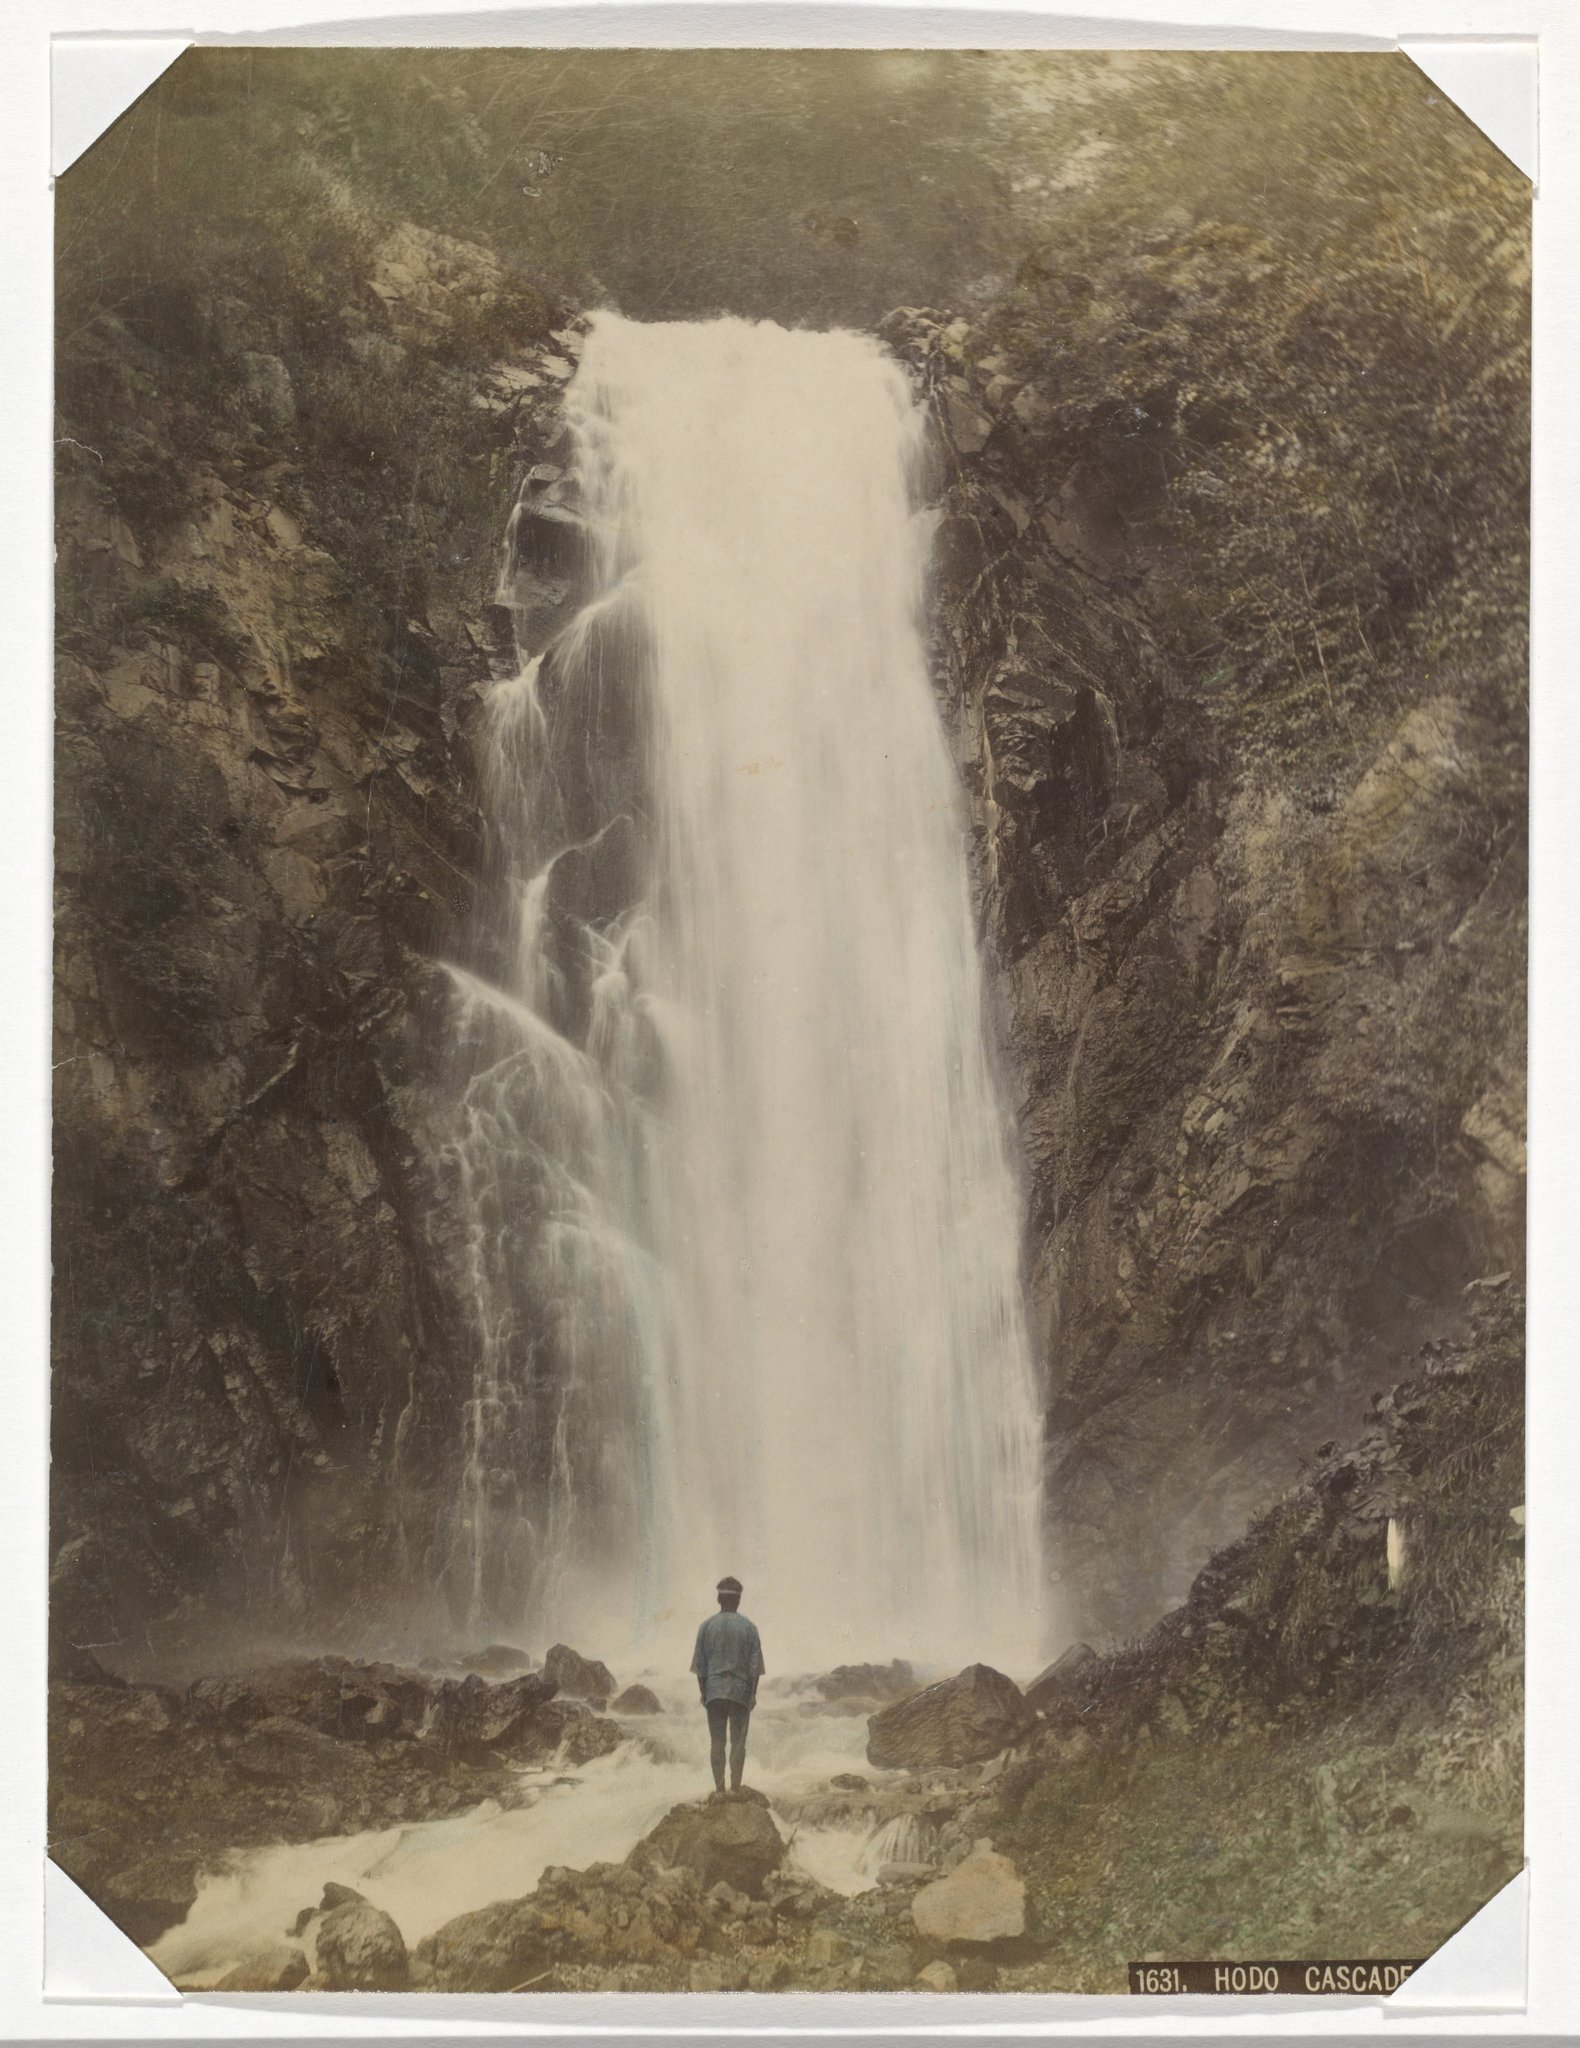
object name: photograph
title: Hodo-waterval bij Nikko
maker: raimund von stillfried-ratenitz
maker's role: painter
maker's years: 1839-1911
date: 1871-1885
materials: cardboard, paper, photographic support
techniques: albumen print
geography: nikko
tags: waterfall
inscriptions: negative number: ‘1631’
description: Onderdeel van Album met 69 foto's van een reis door Japan.